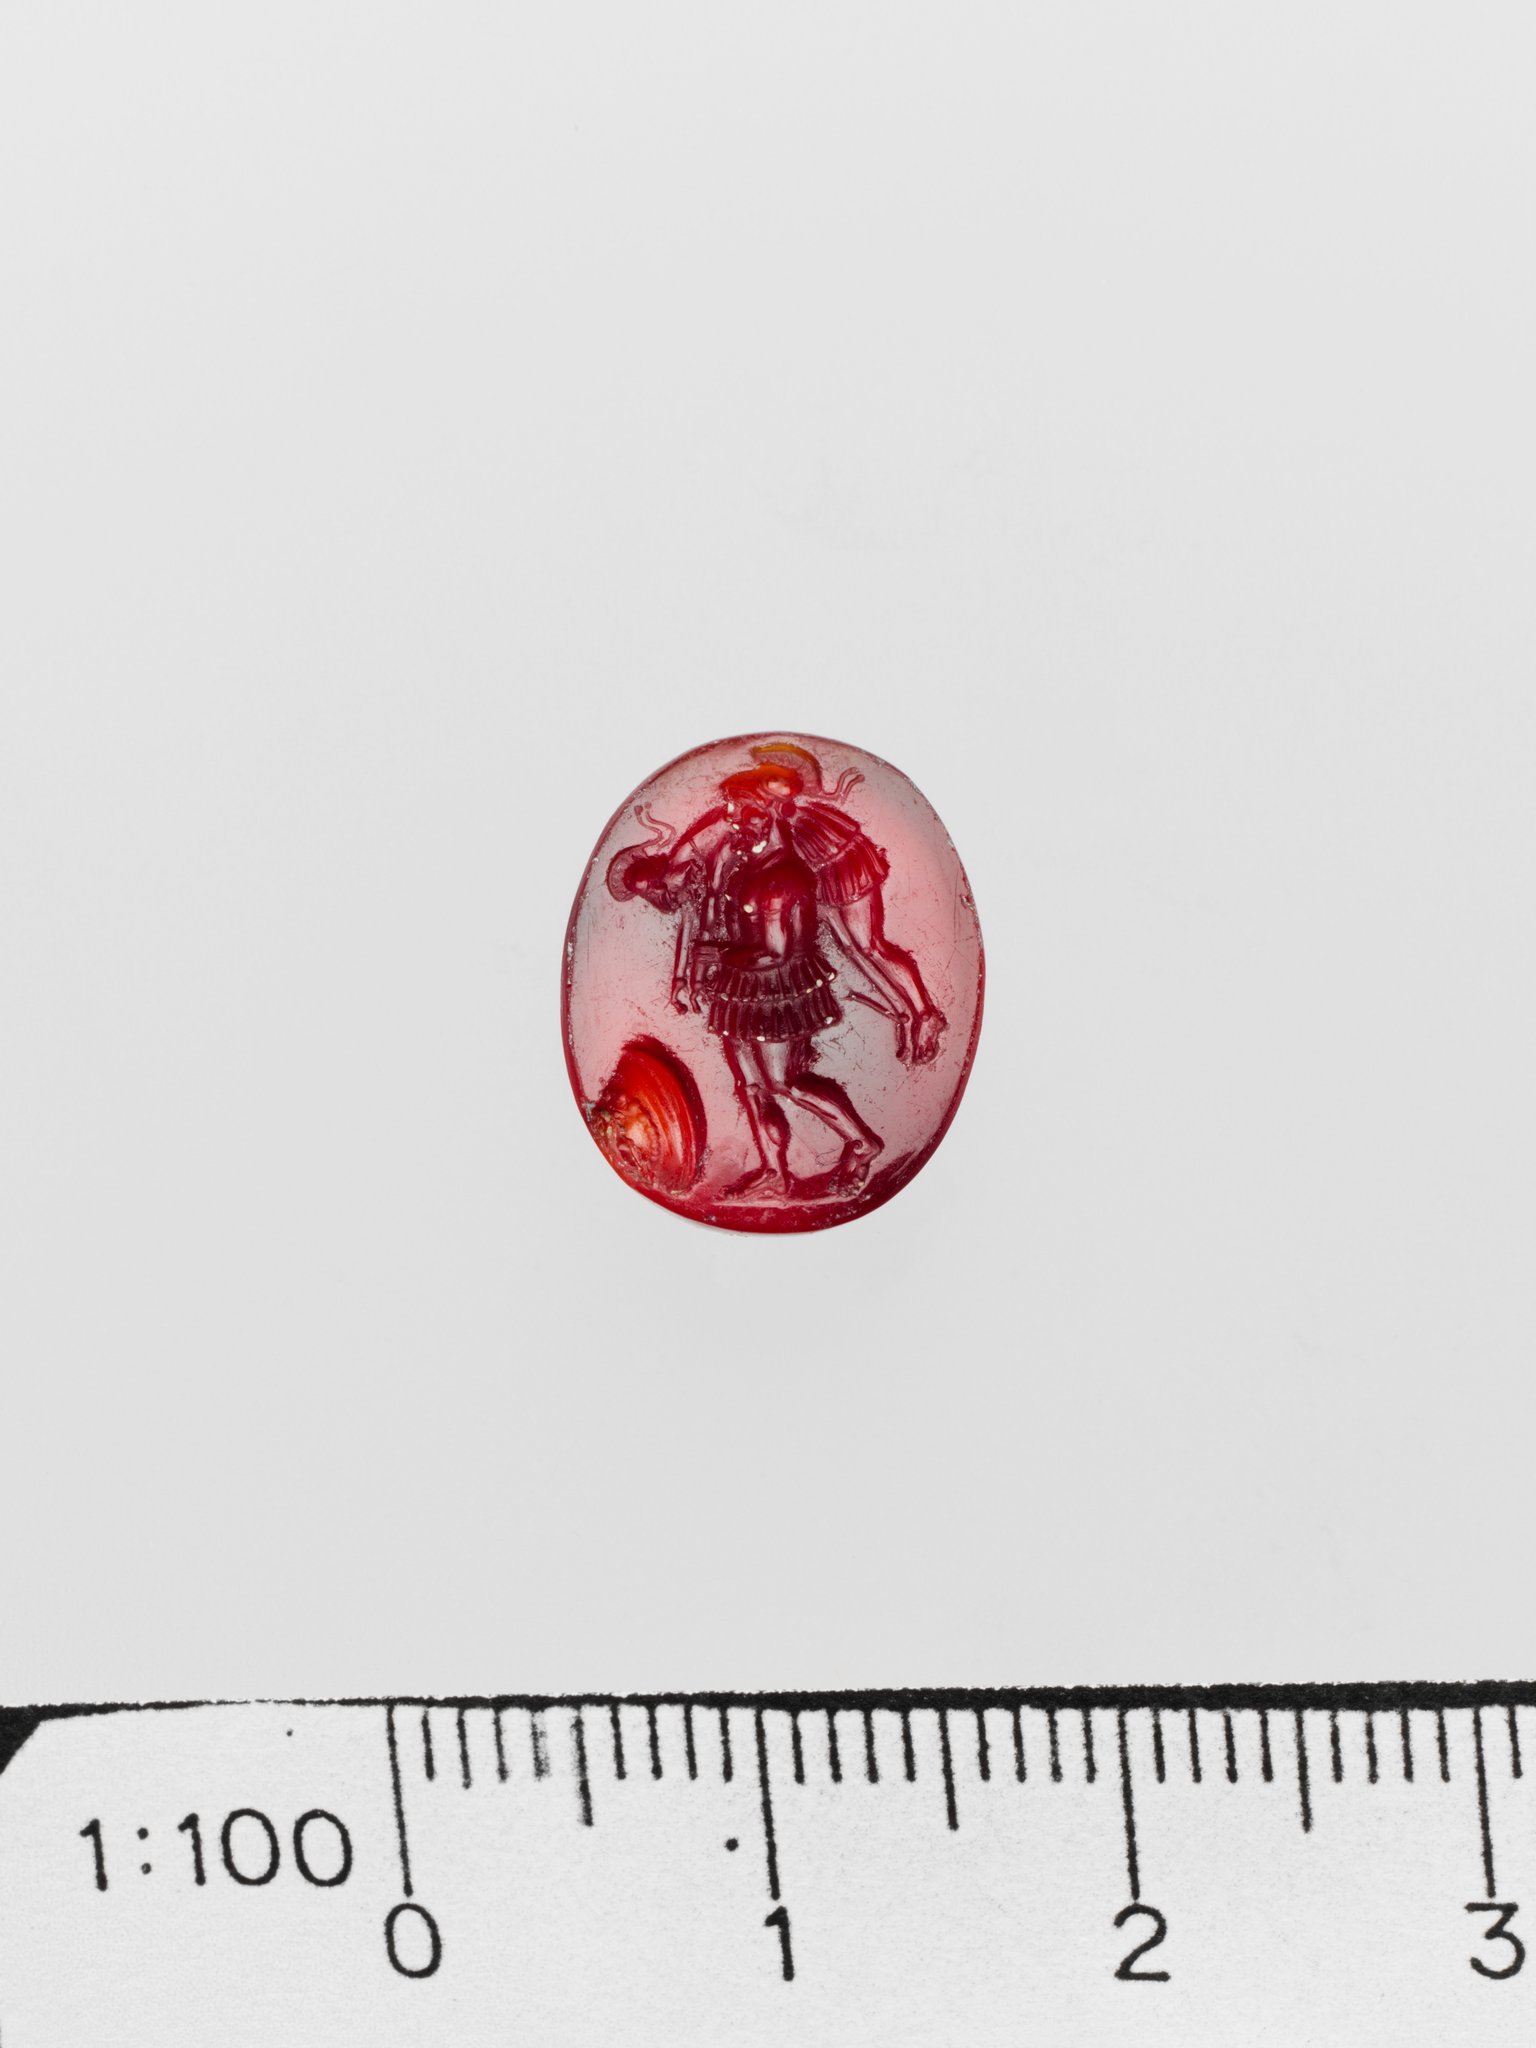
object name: intaglio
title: Carnelian ring stone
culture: italic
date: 300-101 BCE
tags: men,death